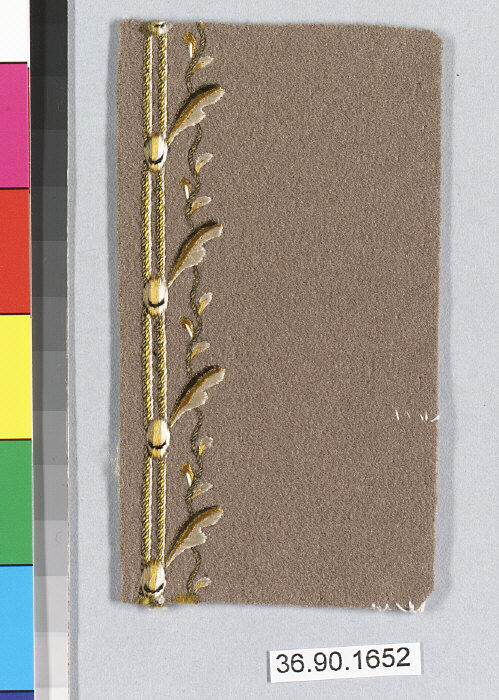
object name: sample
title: Embroidery sample for a man’s suit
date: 1785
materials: silk, wool